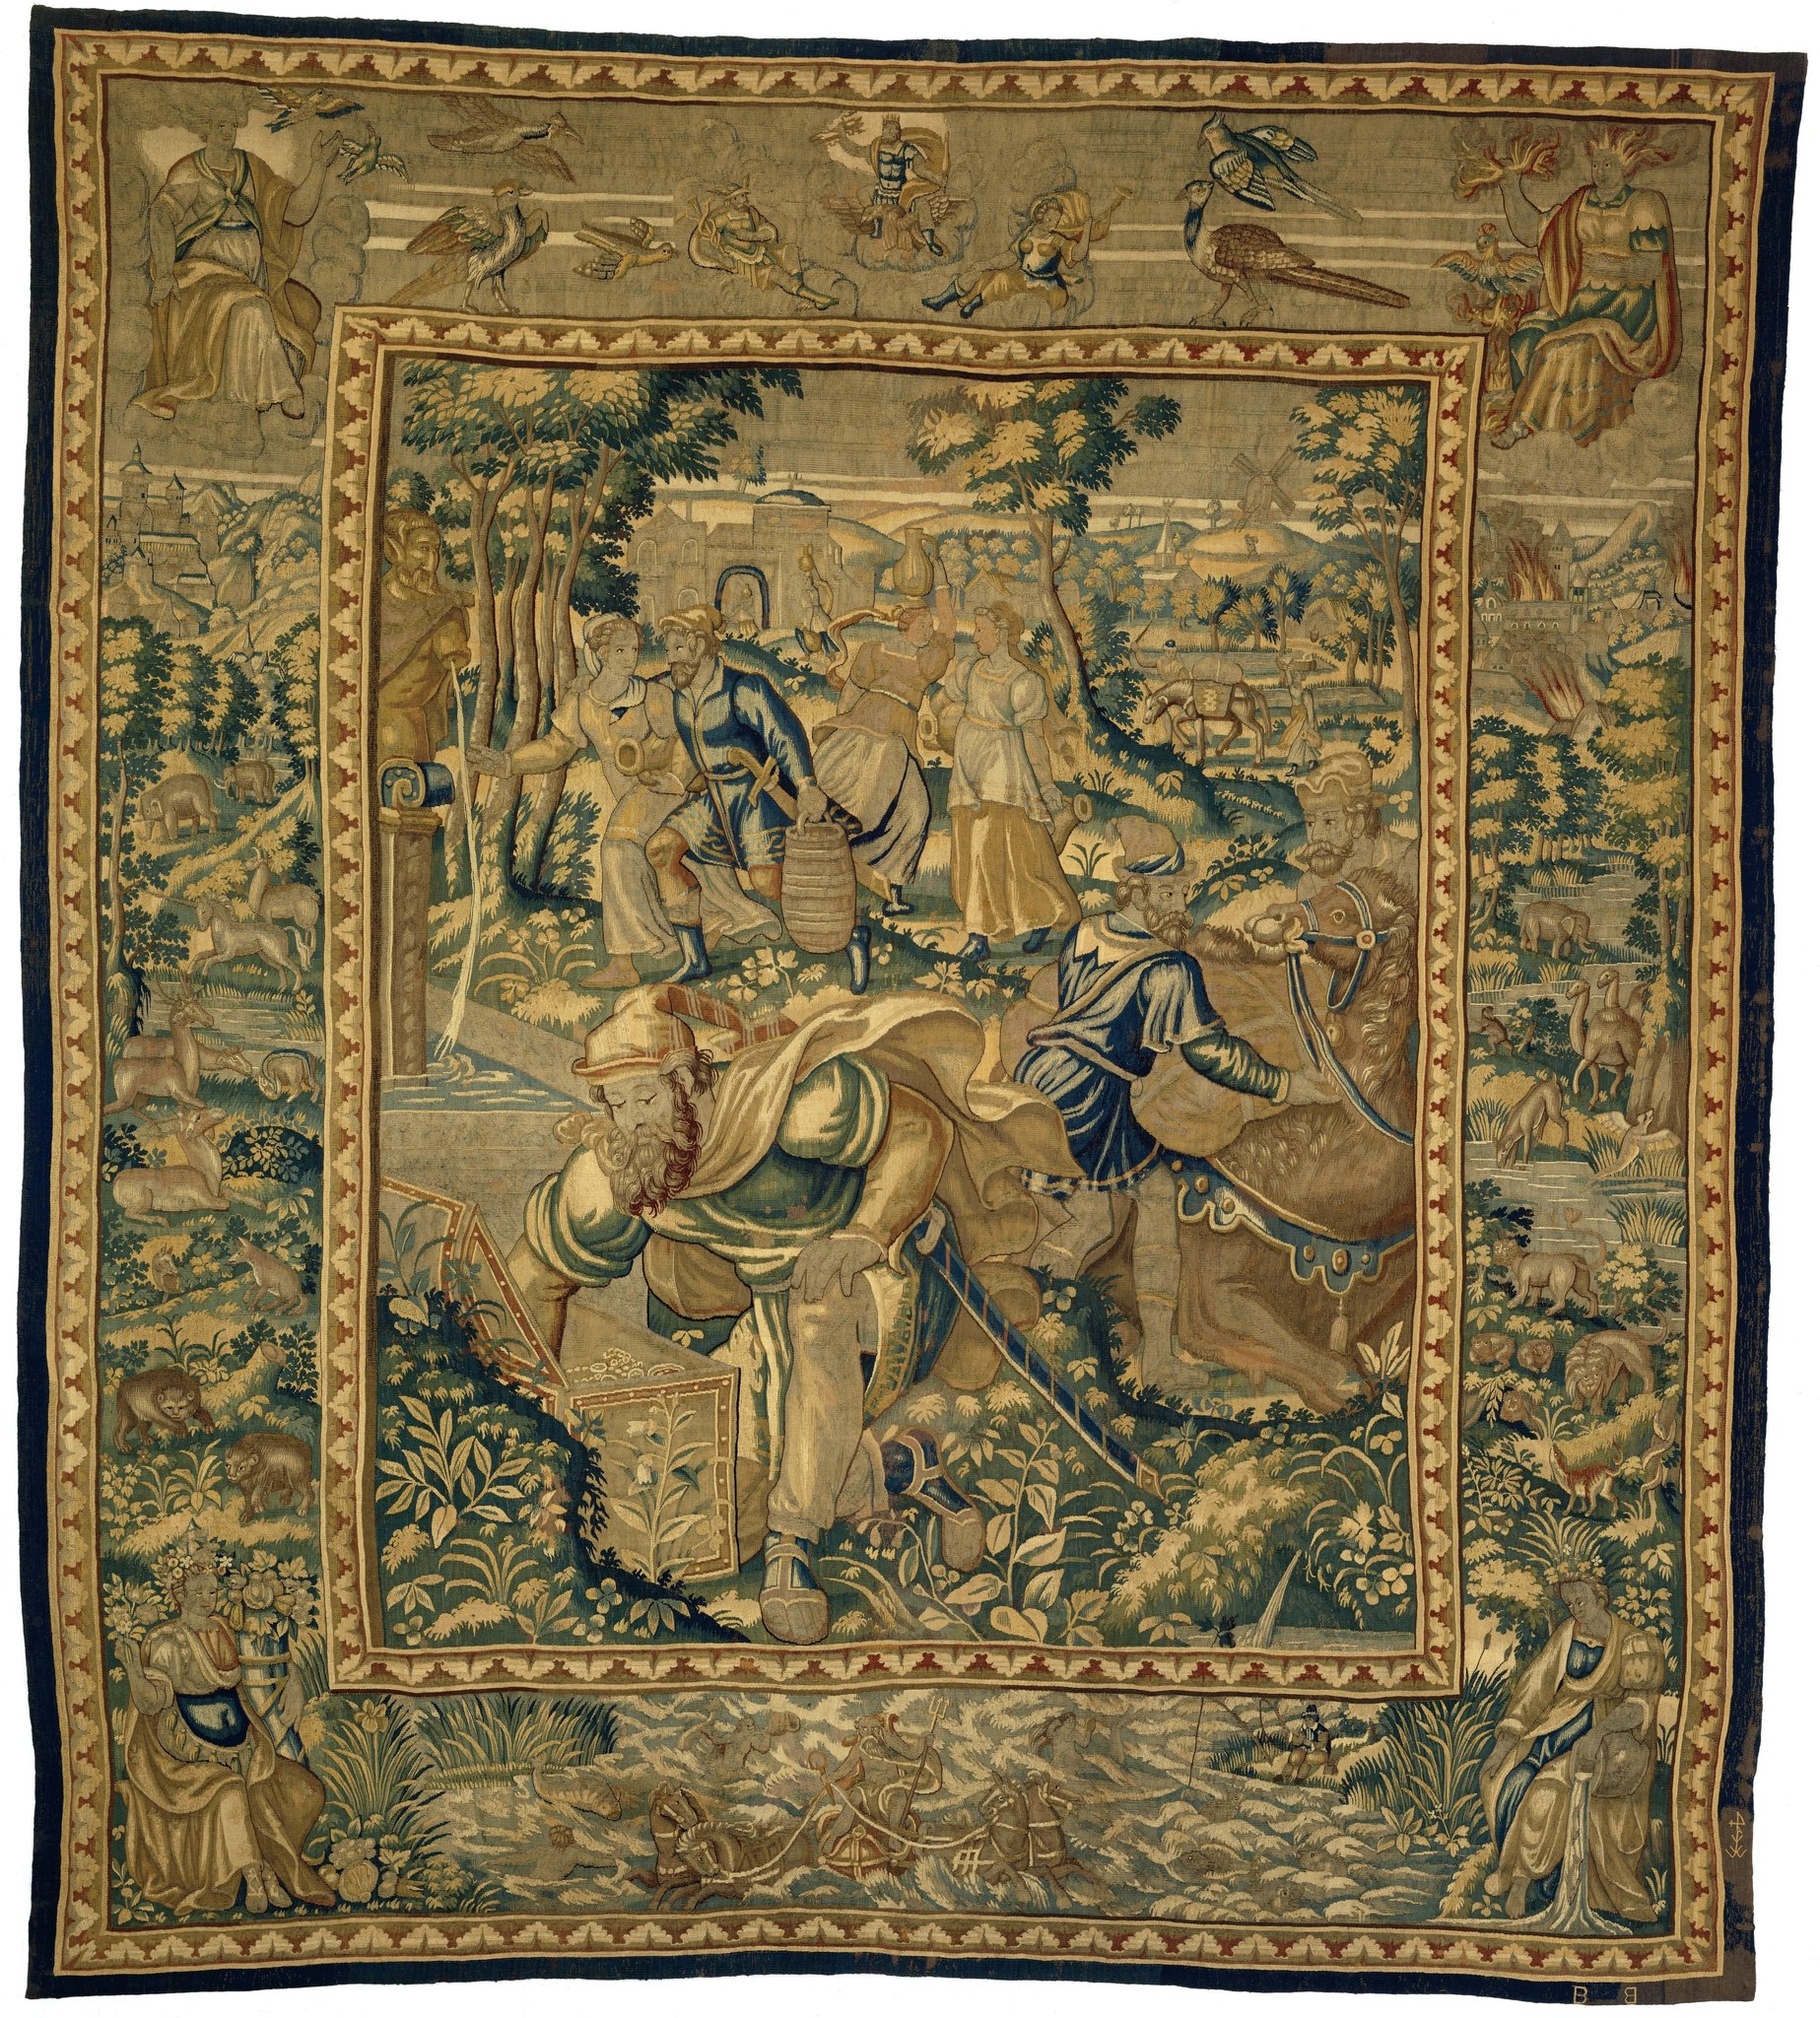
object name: tapestry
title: De aankomst van Eliëzer bij de bron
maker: Anonymous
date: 1575-1600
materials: silk, wool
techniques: tapestry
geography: brussels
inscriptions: town mark: ‘B B’, weaver's mark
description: Wandtapijt met de aankomst van Eliezer (Gen. 24 en 29), uit een serie wandtapijten met de geschiedenis van Rebekka en Eliëzer (Gen.24) met randen met dieren en in de hoeken de vier elementen; met het weversmerk van Willem de Kempeneere.